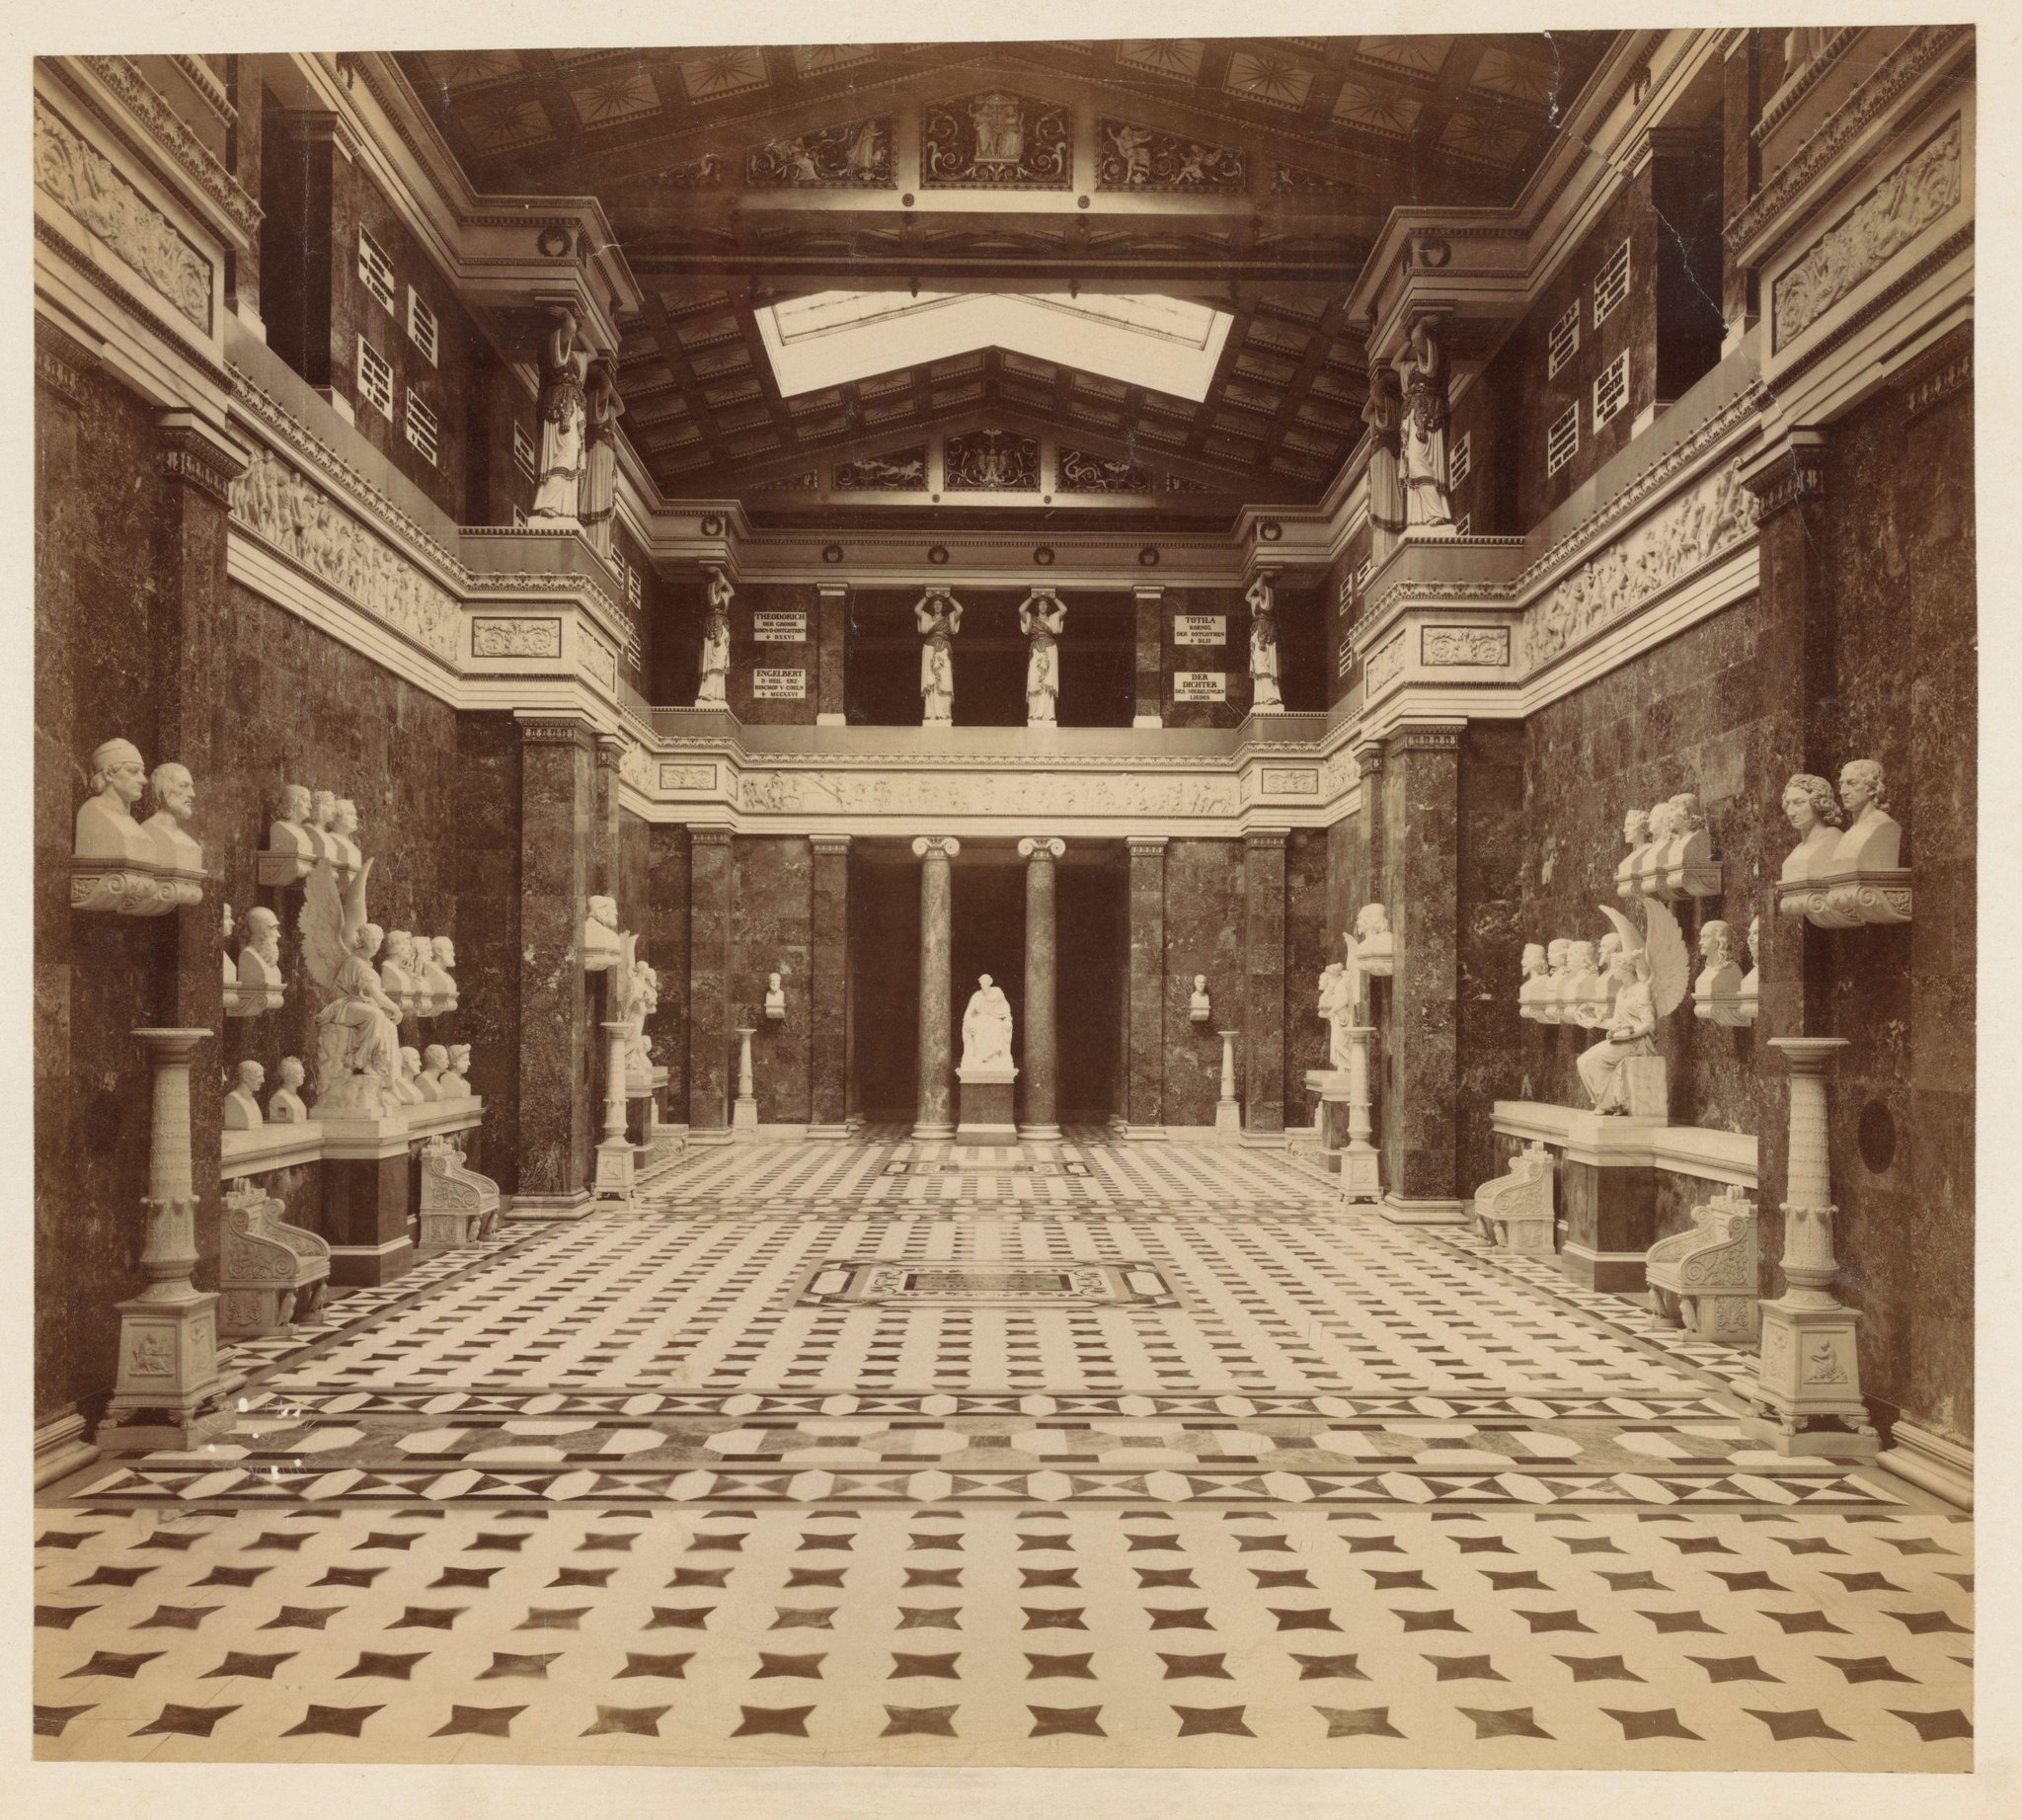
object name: photograph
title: Interieur van het Walhalla te Donaustauf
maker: h. hoffmann (regensburg)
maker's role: fotograaf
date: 1891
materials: cardboard, paper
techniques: albumen print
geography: donaustauf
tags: piece of sculpture, reproduction of a piece of sculpture, permanent exhibition, museum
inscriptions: check stamp: ‘H. Hoffmann/ 1891/ Regensburg’